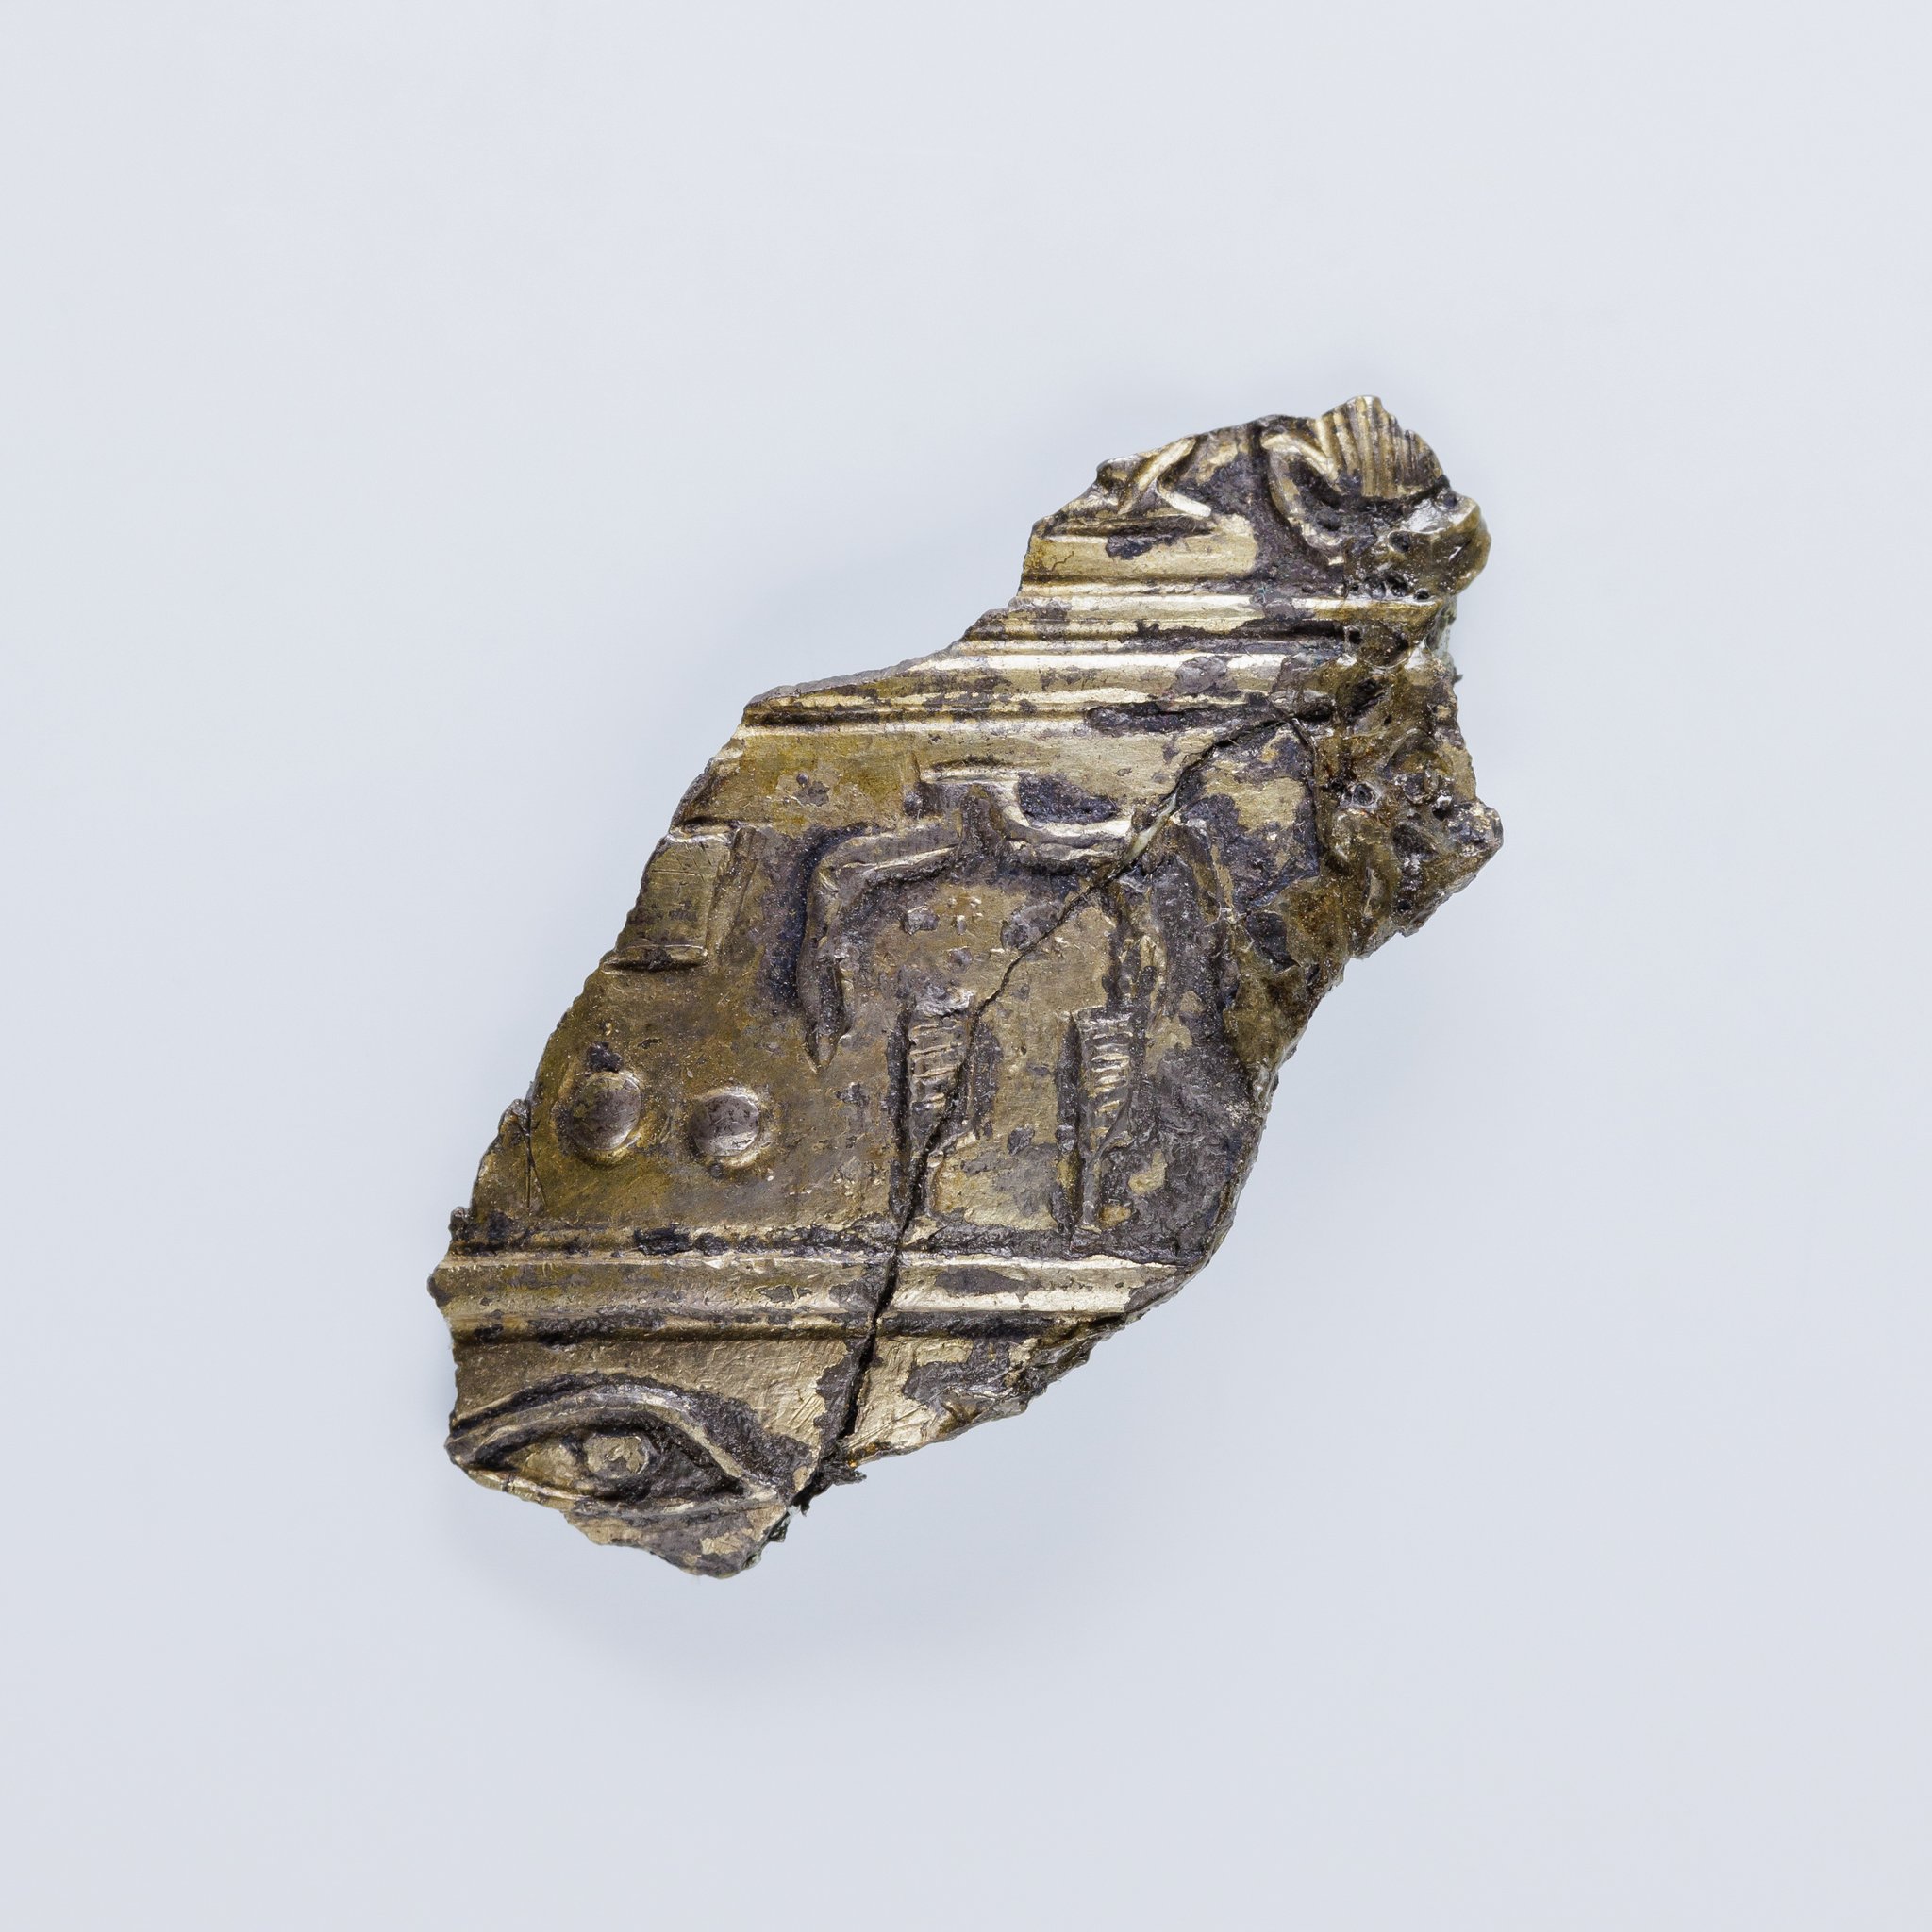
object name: vessel fragment, tell basta treasure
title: Vessel fragments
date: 1070-712 BCE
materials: silver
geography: egypt